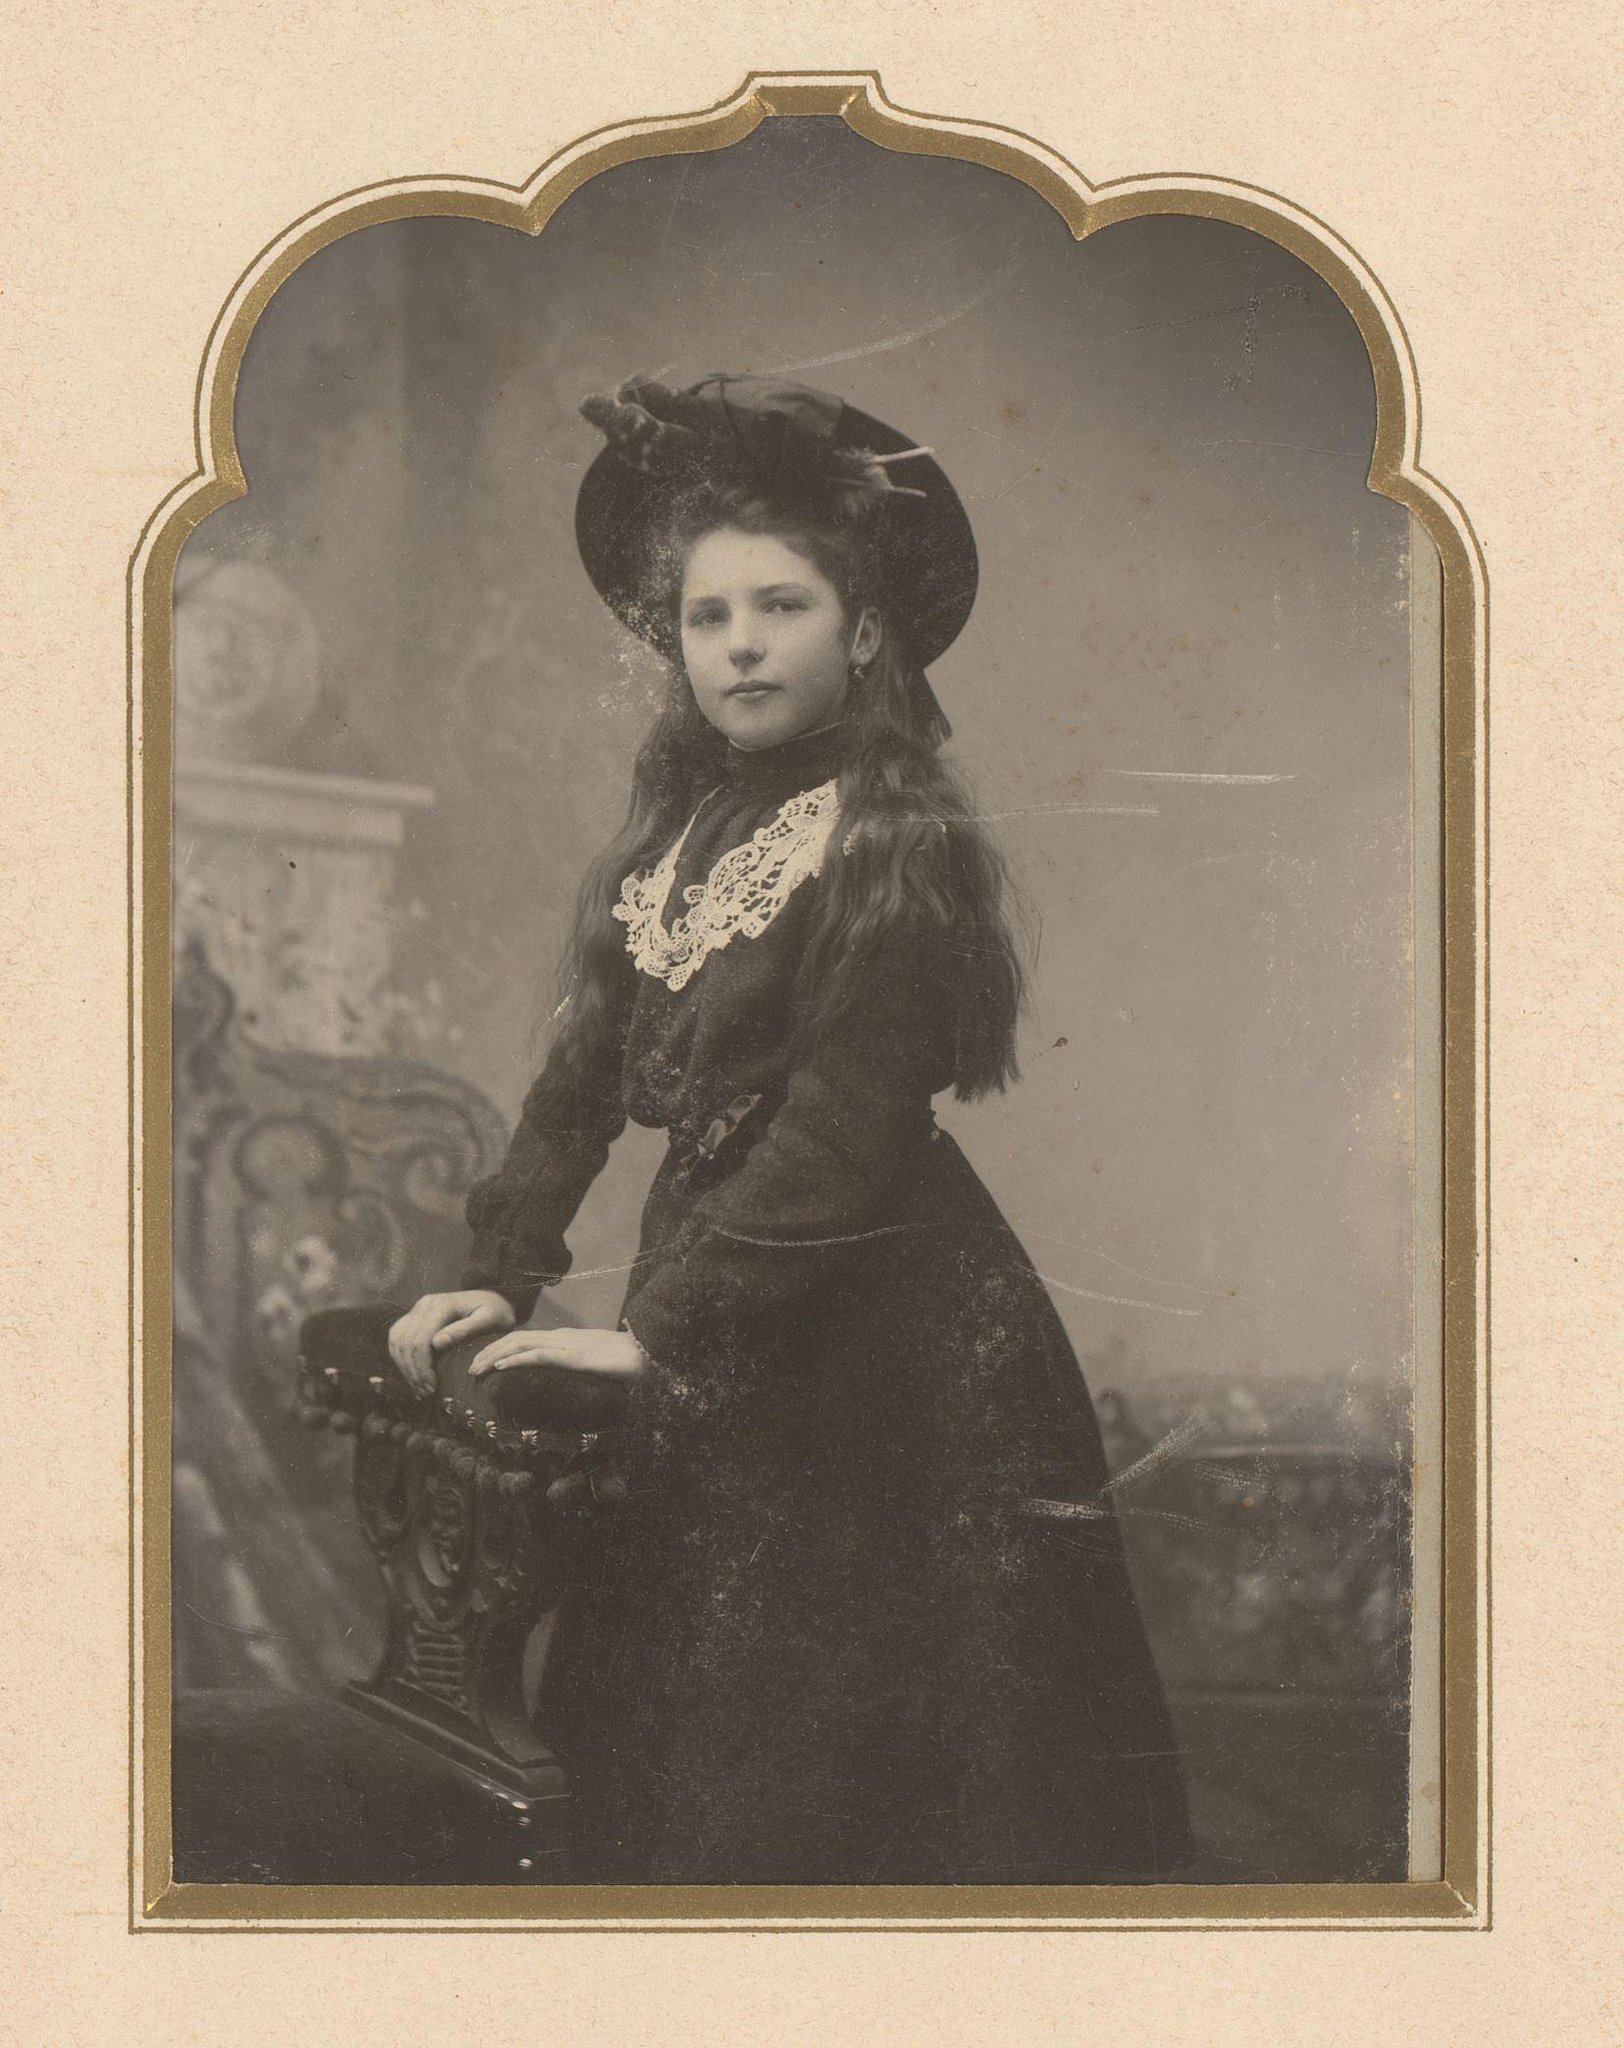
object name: photograph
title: Portret van een staand meisje met hoed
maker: charles guignet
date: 1890-1920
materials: cardboard, photographic support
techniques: collodion silver print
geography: lausanne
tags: girl (child between toddler and youth), head-gear: hat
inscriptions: inscription: ‘Charles Guignet/ Lausanne/ Téléphone 1502/ Pontaise (...)’